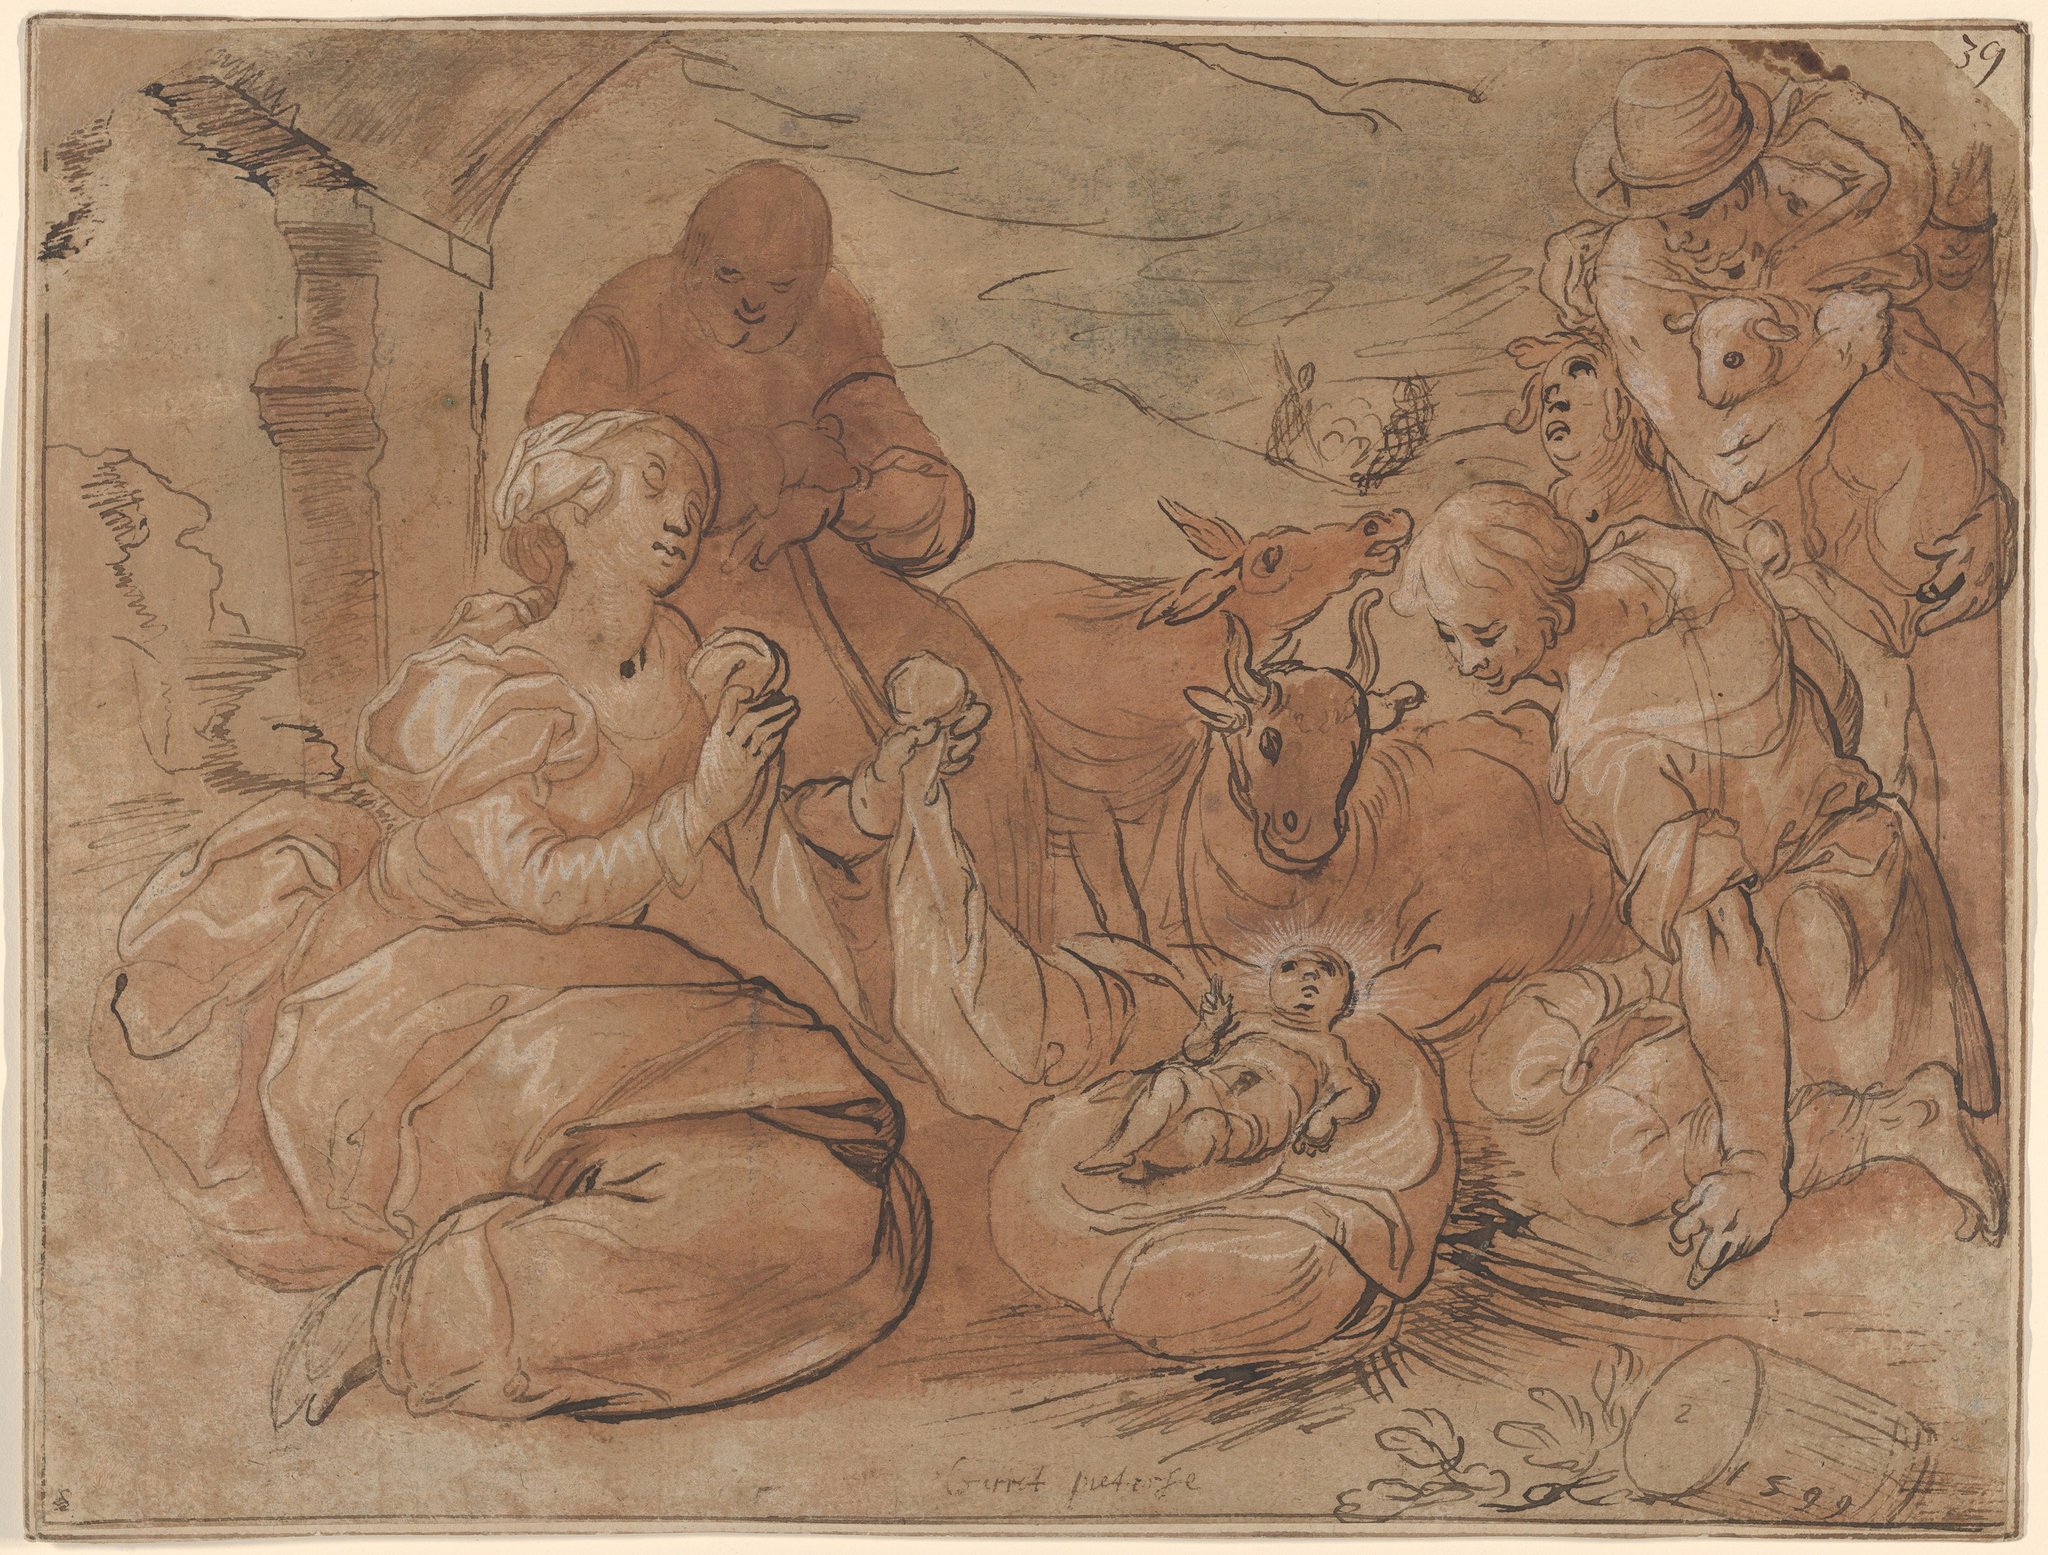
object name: drawing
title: The Adoration of the Shepherds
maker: gerrit pietersz. sweelink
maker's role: artist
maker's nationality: netherlandish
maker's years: 1566-1612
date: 1599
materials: gouache, ink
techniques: heightening, pen, wash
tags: animals,women,adoration of the shepherds